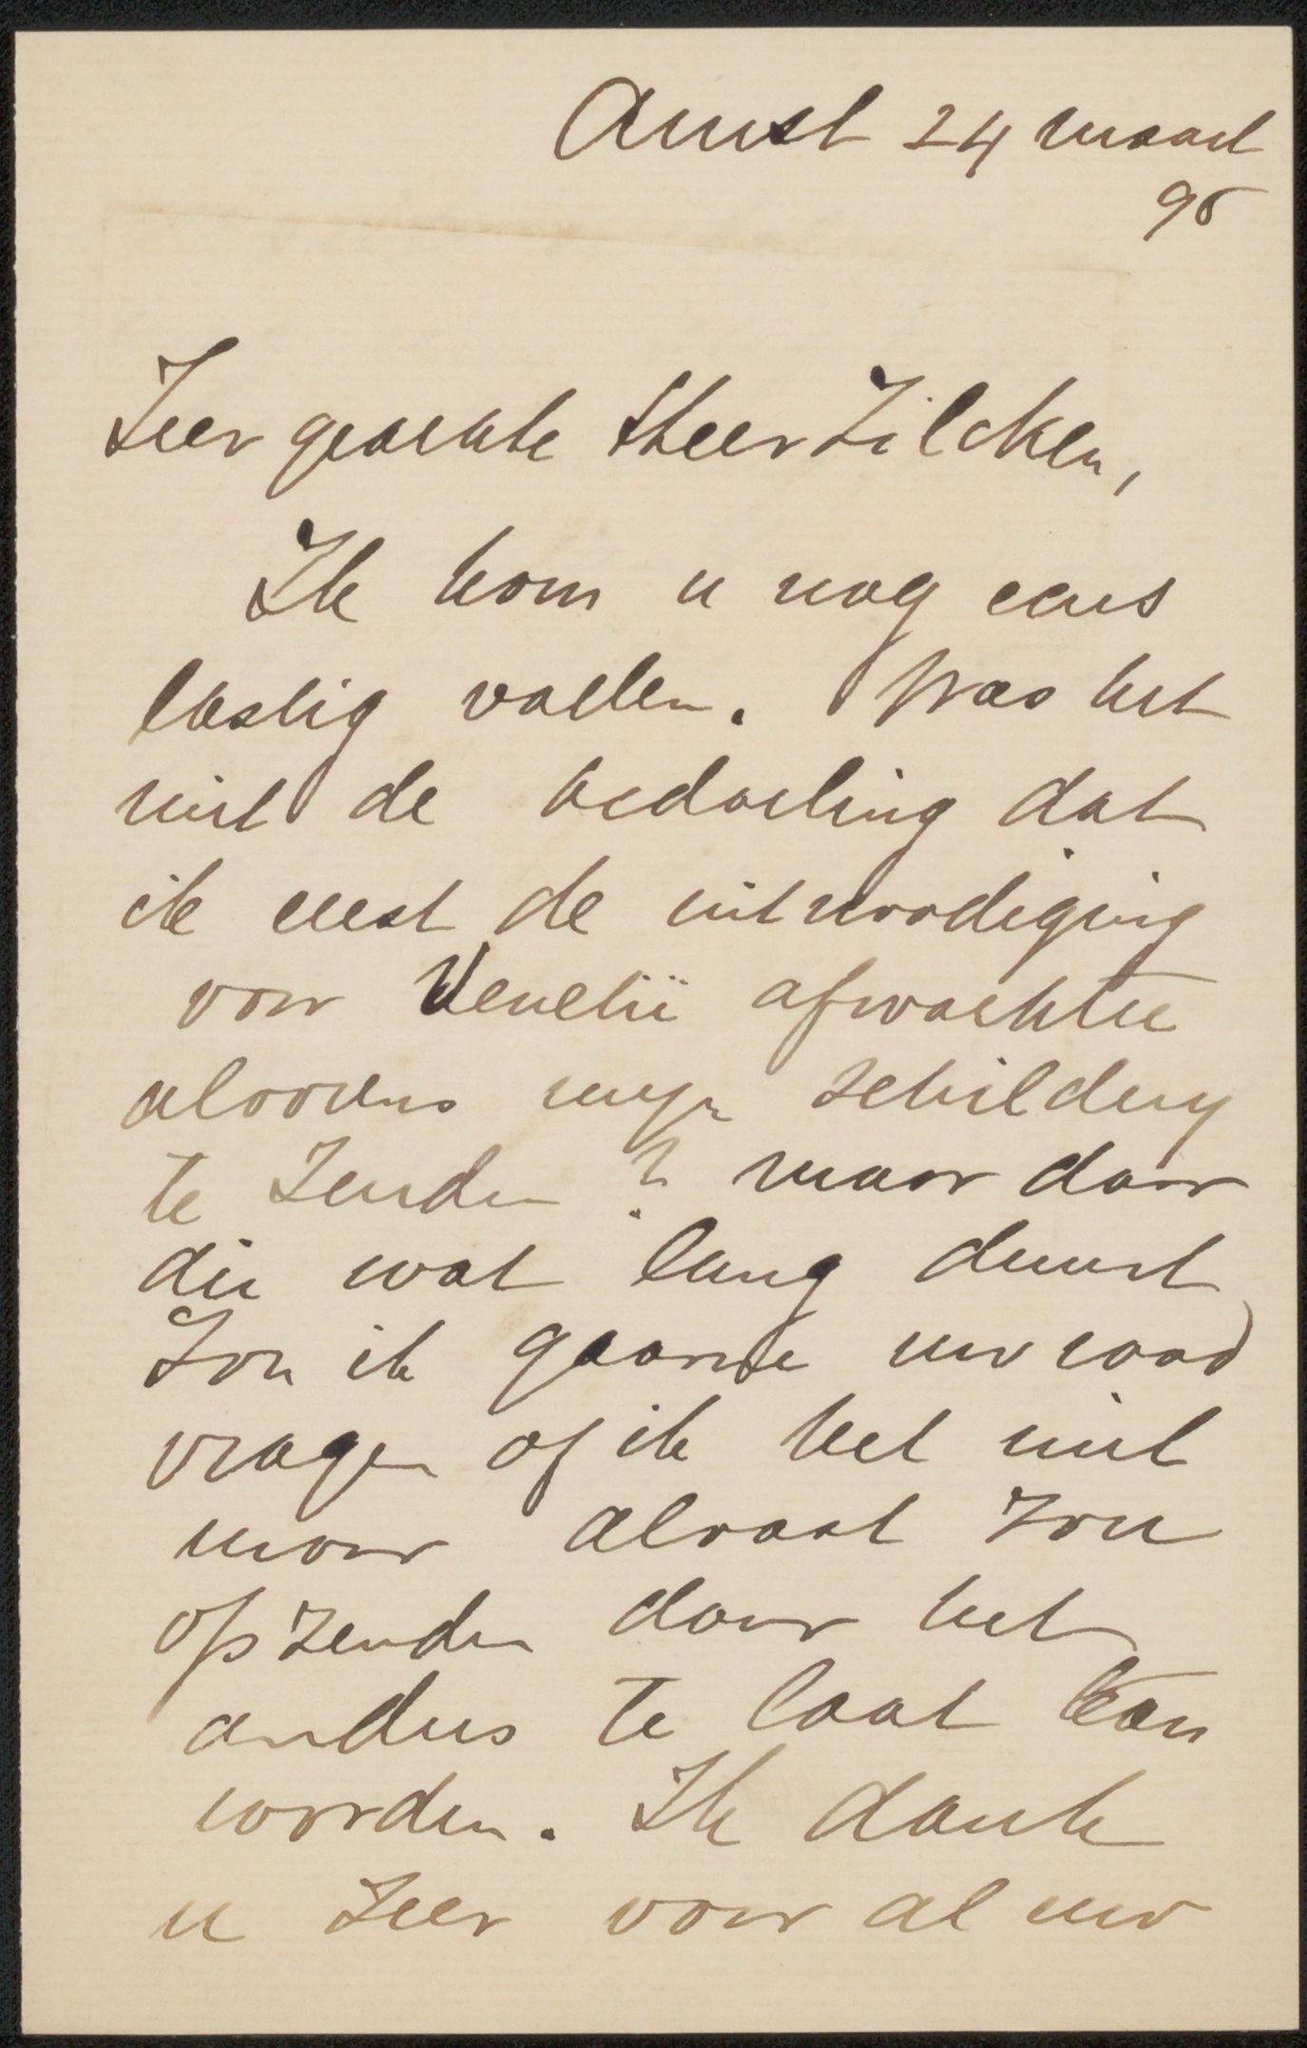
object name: letter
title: Brief aan Philip Zilcken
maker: thérèse schwartze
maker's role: draughtsman, painter, print maker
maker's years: 1851-1918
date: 1895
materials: ink, paper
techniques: pen, writing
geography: amsterdam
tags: the hague, philip zilcken, exhibition ~ art, venice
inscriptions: watermark, collector's mark: ‘RPK’